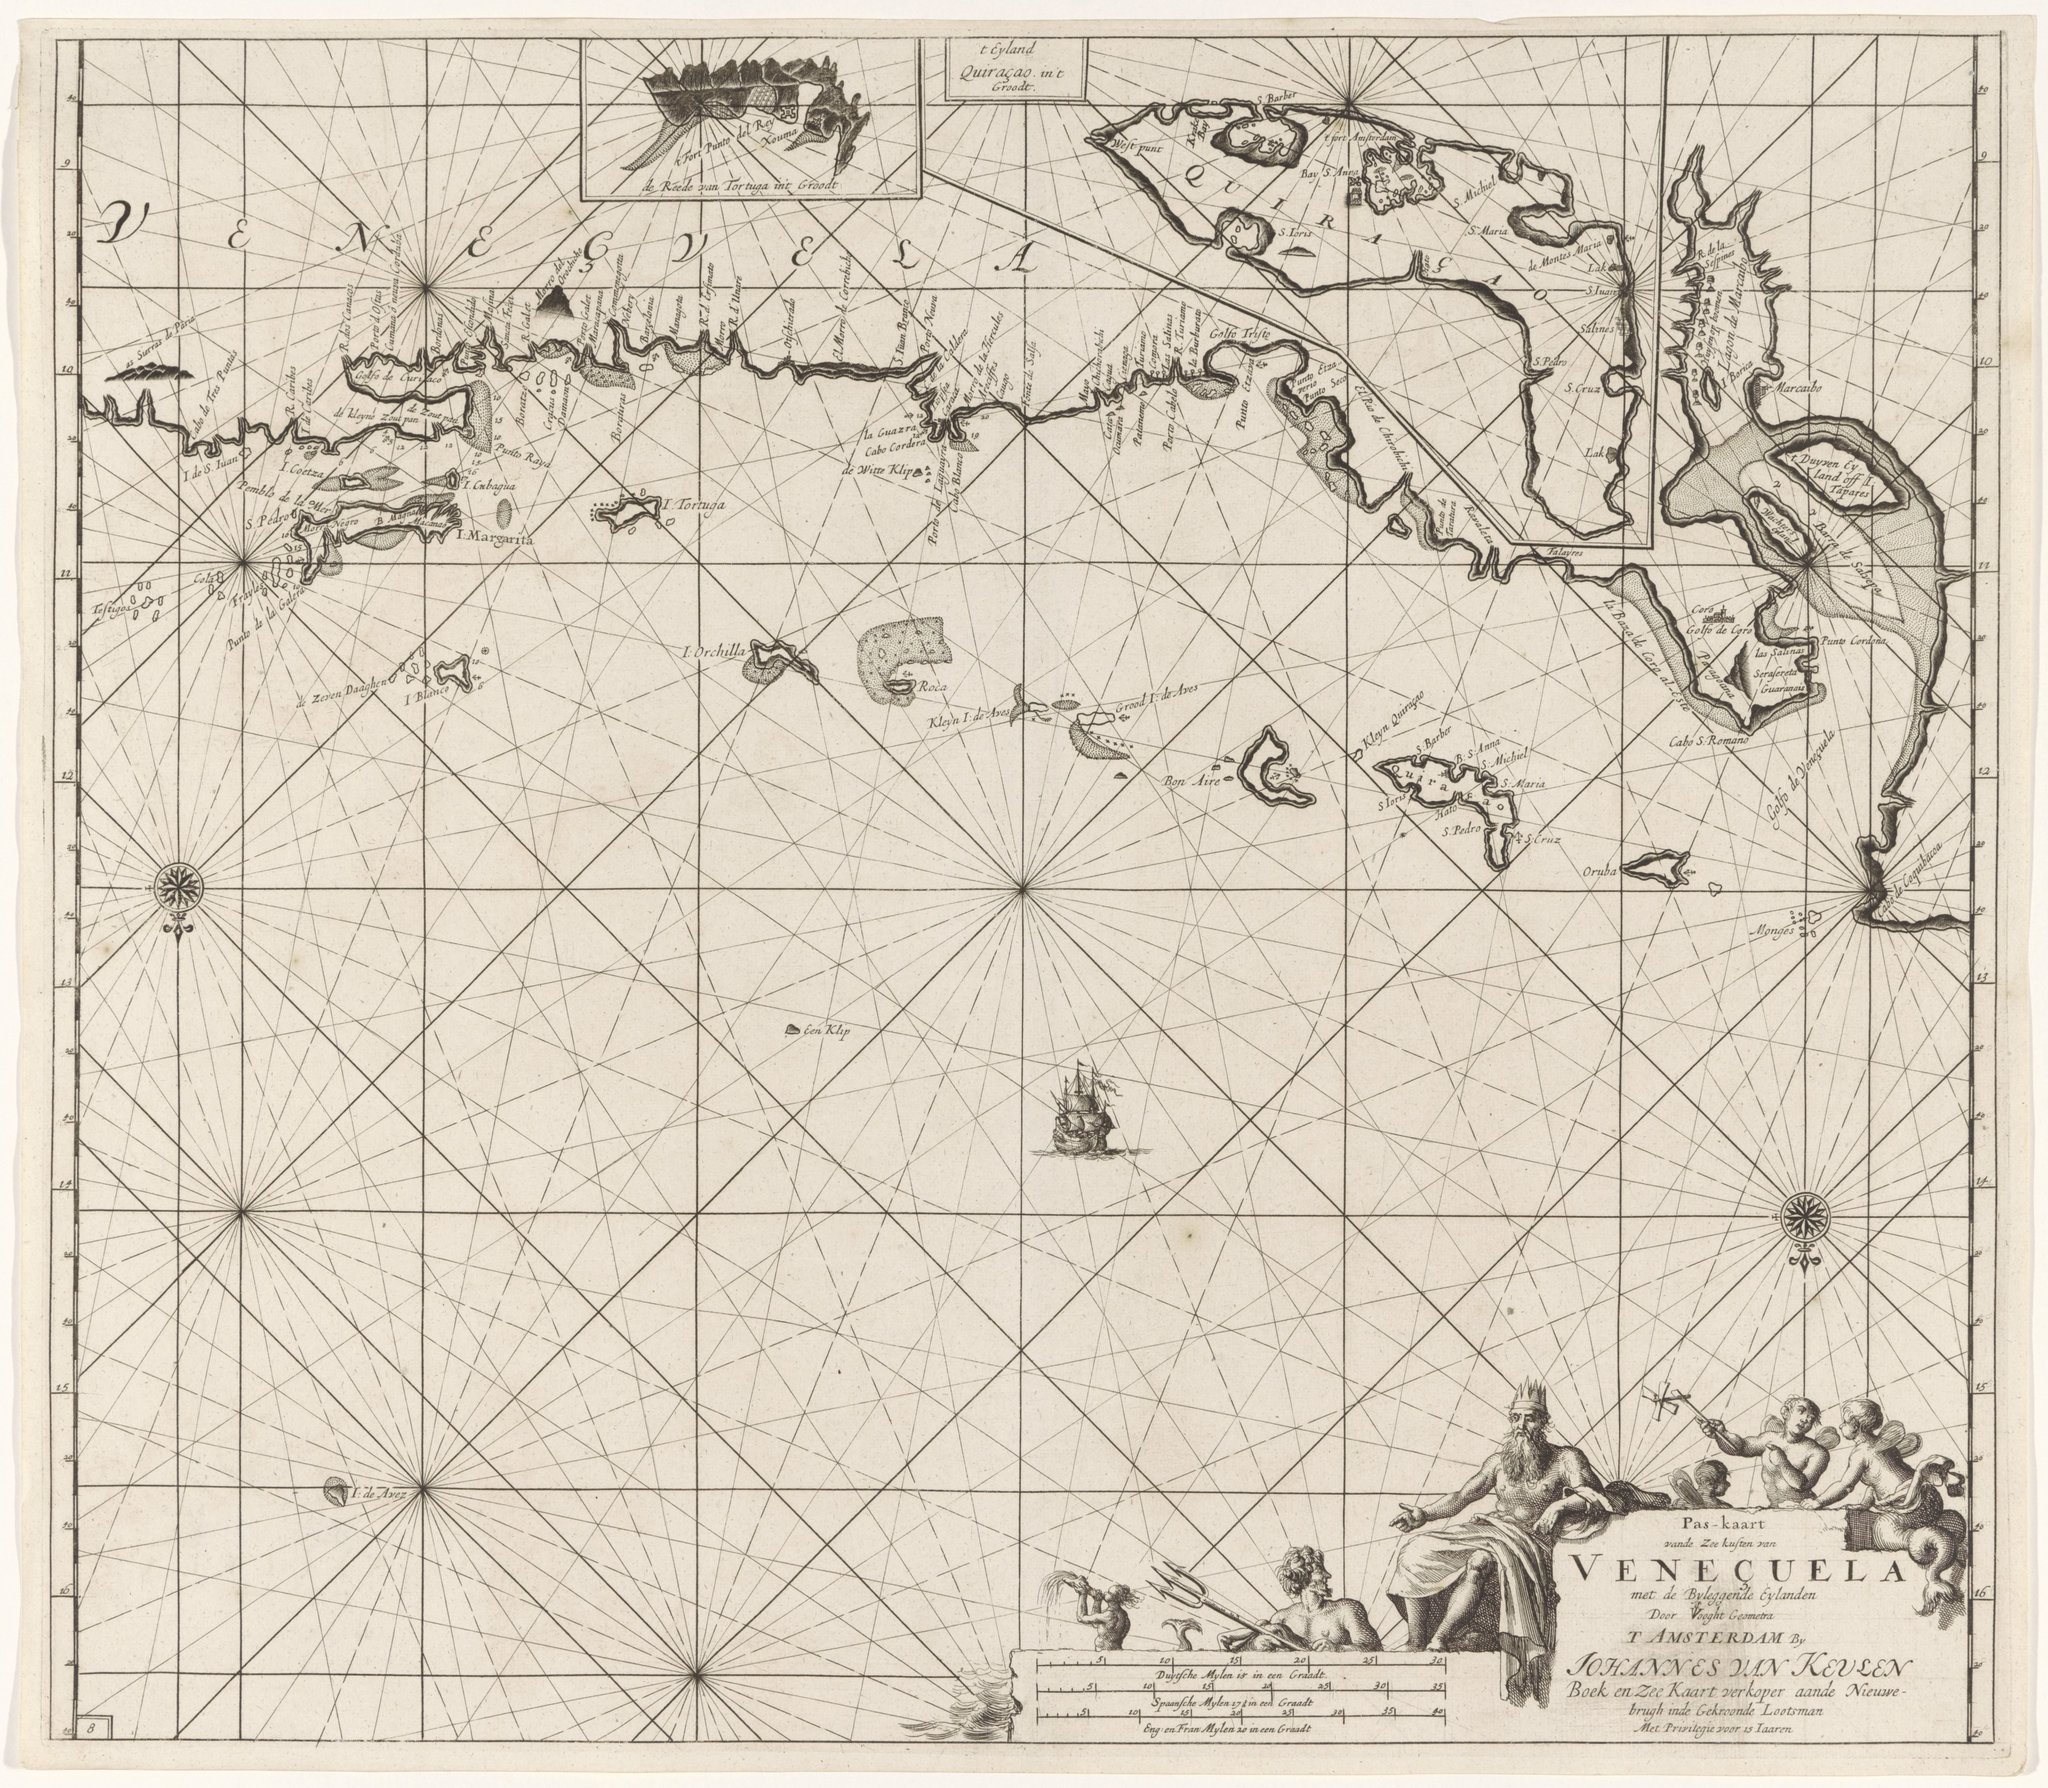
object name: print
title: Pas-kaart vande Zee kusten van Veneçuela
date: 1684-1799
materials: paper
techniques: engraving, etching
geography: amsterdam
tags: sailing-ship, sailing-boat, merman, ruler, sovereign - bb - female ruler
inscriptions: collector's mark: Lugt 2228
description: Paskaart van de kust van Venezuela met de Benedenwindse Eilanden, met inzetkaarten van de rede van Tortuga en een kaart van Curaçao. Met twee windrozen, het Noorden ligt onder. Rechtsonder de titel, het adres van de uitgever en de schaalverdeling, weergegeven in Duitse, Spaanse en Engelse of Franse mijlen (schaal: c. 1:1.800.000). De gegevens zijn versierd met een zittende Neptunus, een meerman en bazuin blazende triton en verschillende meermannen, waarvan een met een windmolentje in de hand.